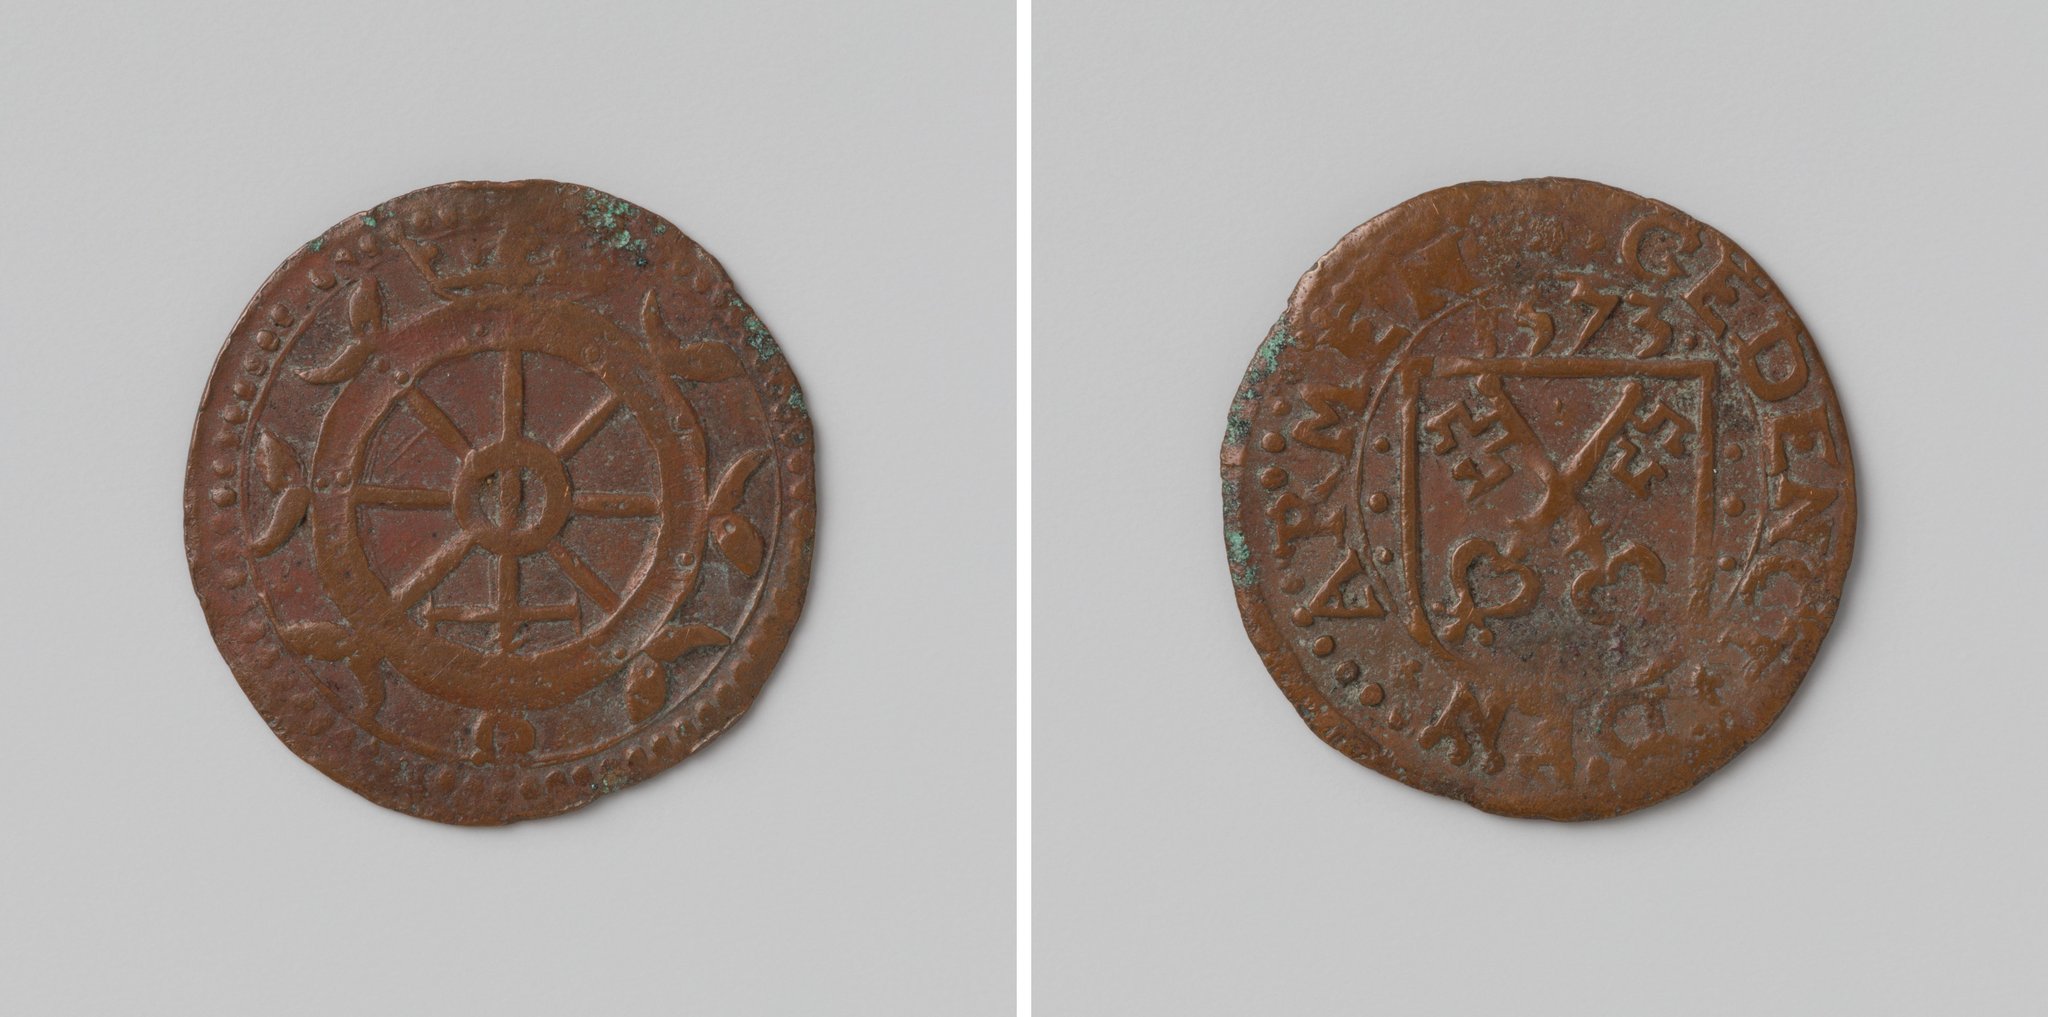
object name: alms token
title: Catharina-gasthuis van Leiden, armenpenning ter waarde van een oord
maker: Anonymous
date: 1573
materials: copper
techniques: striking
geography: leiden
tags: leiden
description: Koperen penning. Voorzijde: gekroond rad. Keerzijde: wapenschild onder jaartal binnen omschrift.